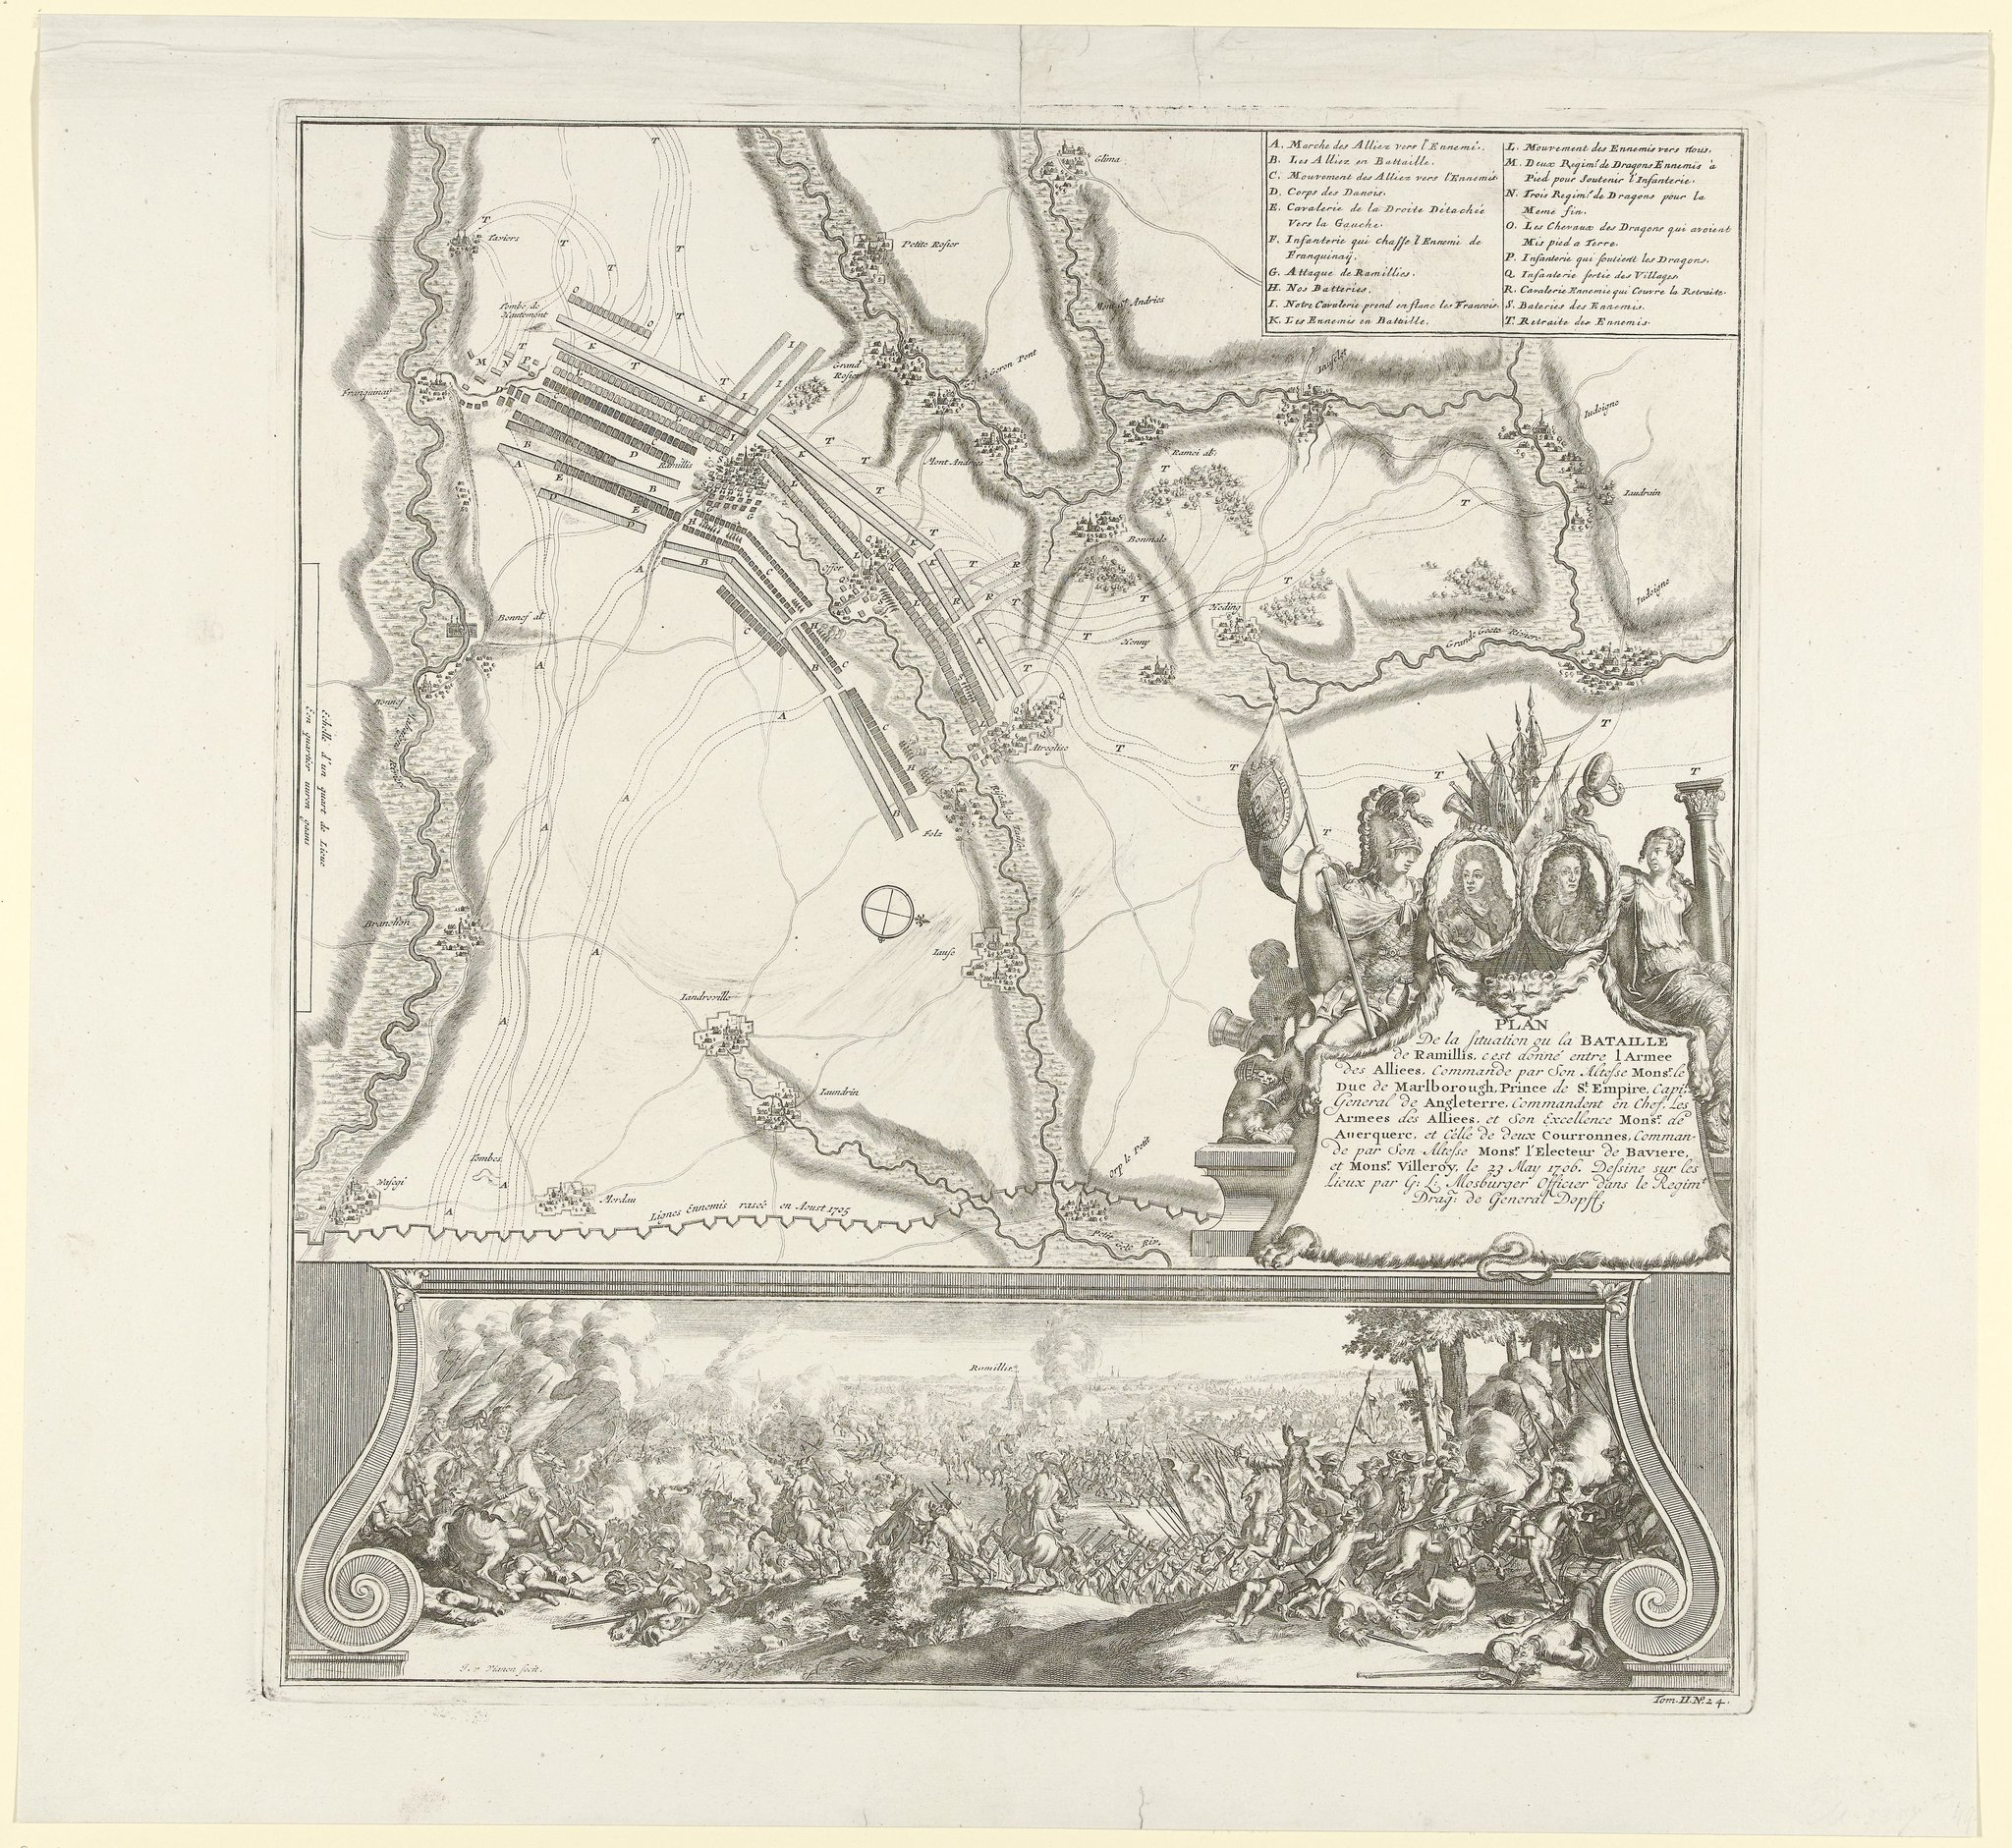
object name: map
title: Plan De la situation ou la Bataille de Ramillis, c'est donné entre l Armee des Alliees (...) 23 May 1706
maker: jan van vianen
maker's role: print maker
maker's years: 1660-1726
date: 1706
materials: paper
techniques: etching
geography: northern netherlands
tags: john churchill (1e hertog van marlborough), the hague, maps of separate countries or regions, battle (+ land forces)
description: Plan en gezicht van de slag bij Ramillies tussen de Geallieerden onder de hertog van Marlborough en Hendrik van Nassau, heer van Ouwerkerk en de Fransen en de Beiersen, 23 mei 1706. Rechts een cartouche versierd met allegorische figuren en de portretten van Marlborough en Ouwerkerk. Genummerd rechtsonder: Tom. II. No. 24.